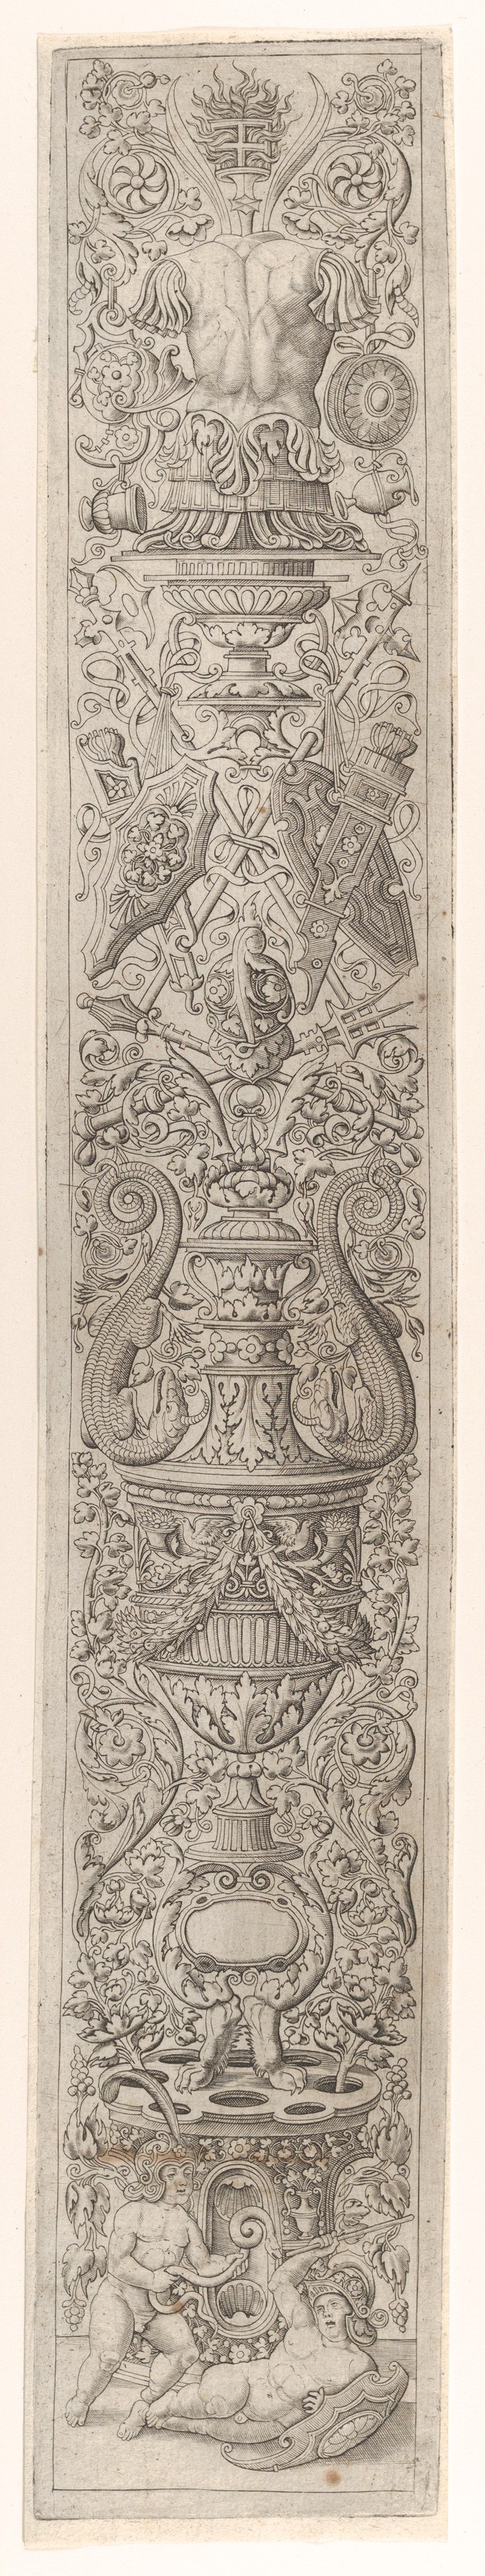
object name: print ornament architecture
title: Candelabra grostesque with two children wearing helmets, from a series of twelve candelabra grotesques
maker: giovanni antonio da brescia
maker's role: artist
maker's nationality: italian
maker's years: 1490-1525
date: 1490-1515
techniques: engraving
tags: helmets,grotesques,ornament,male nudes